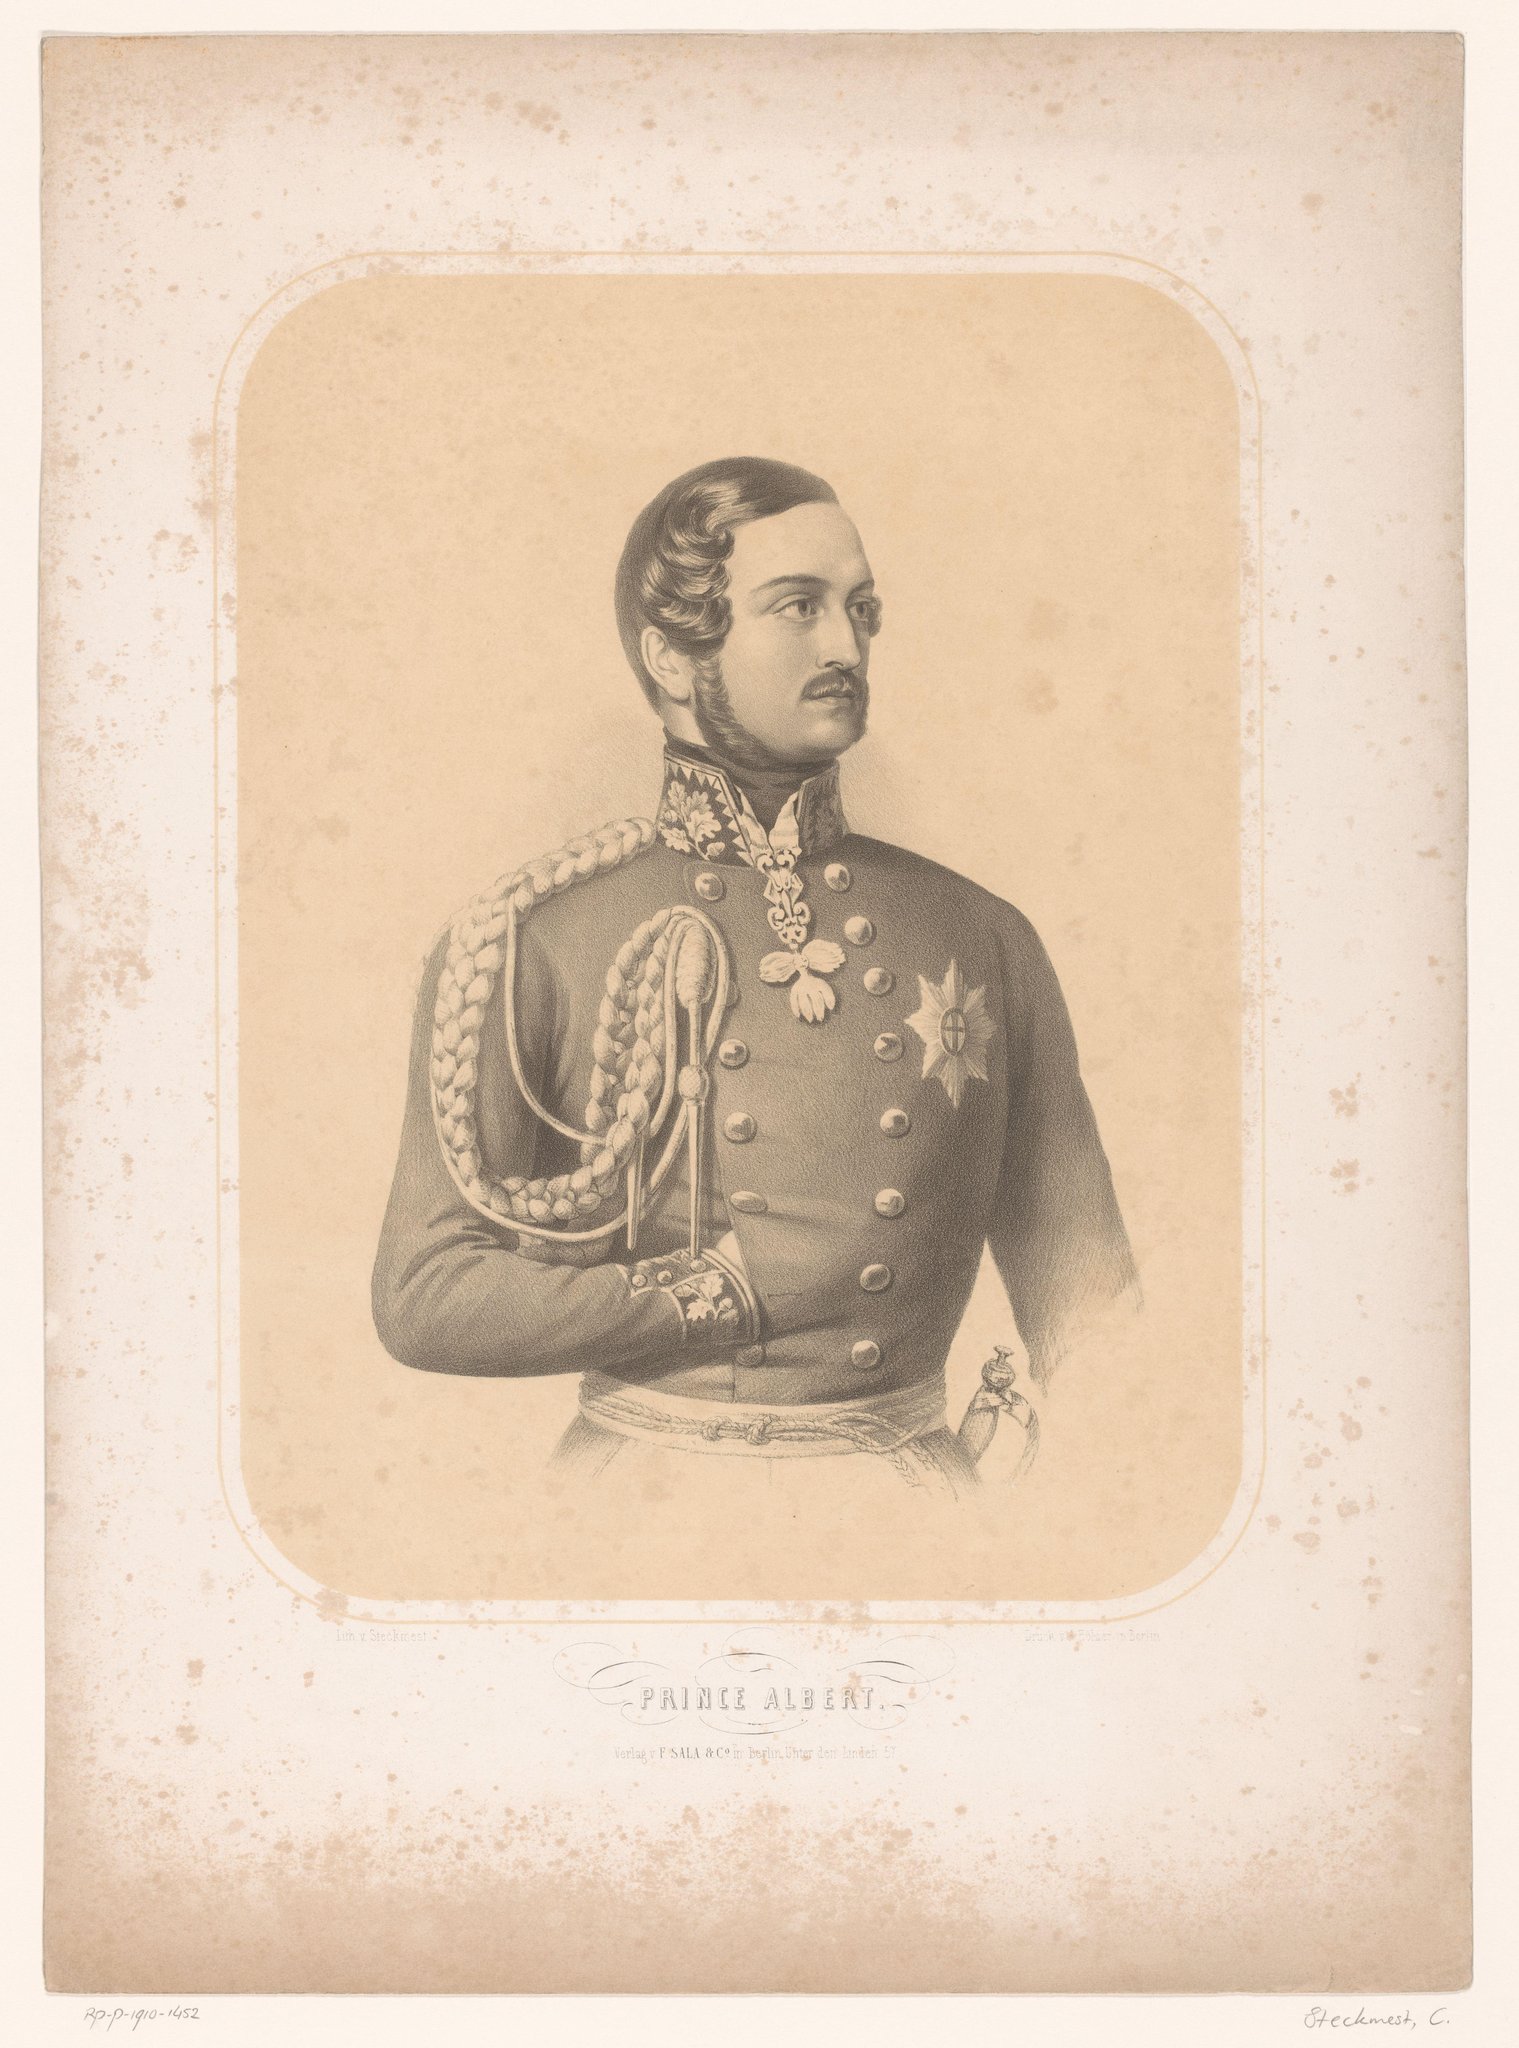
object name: print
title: Portret van Prins Albert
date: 1800-1900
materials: paper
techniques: lithograph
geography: berlin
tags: historical persons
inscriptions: collector's mark: Lugt 2228, signature: ‘Lith. v. Steckmest’, inscription: ‘Prince Albert.’, signature: ‘Verlag v F. SALA & Co in Berlin, Unter den Linden 51.’, signature: ‘Druck v. A. Hölzer in Berlin’, check stamp: